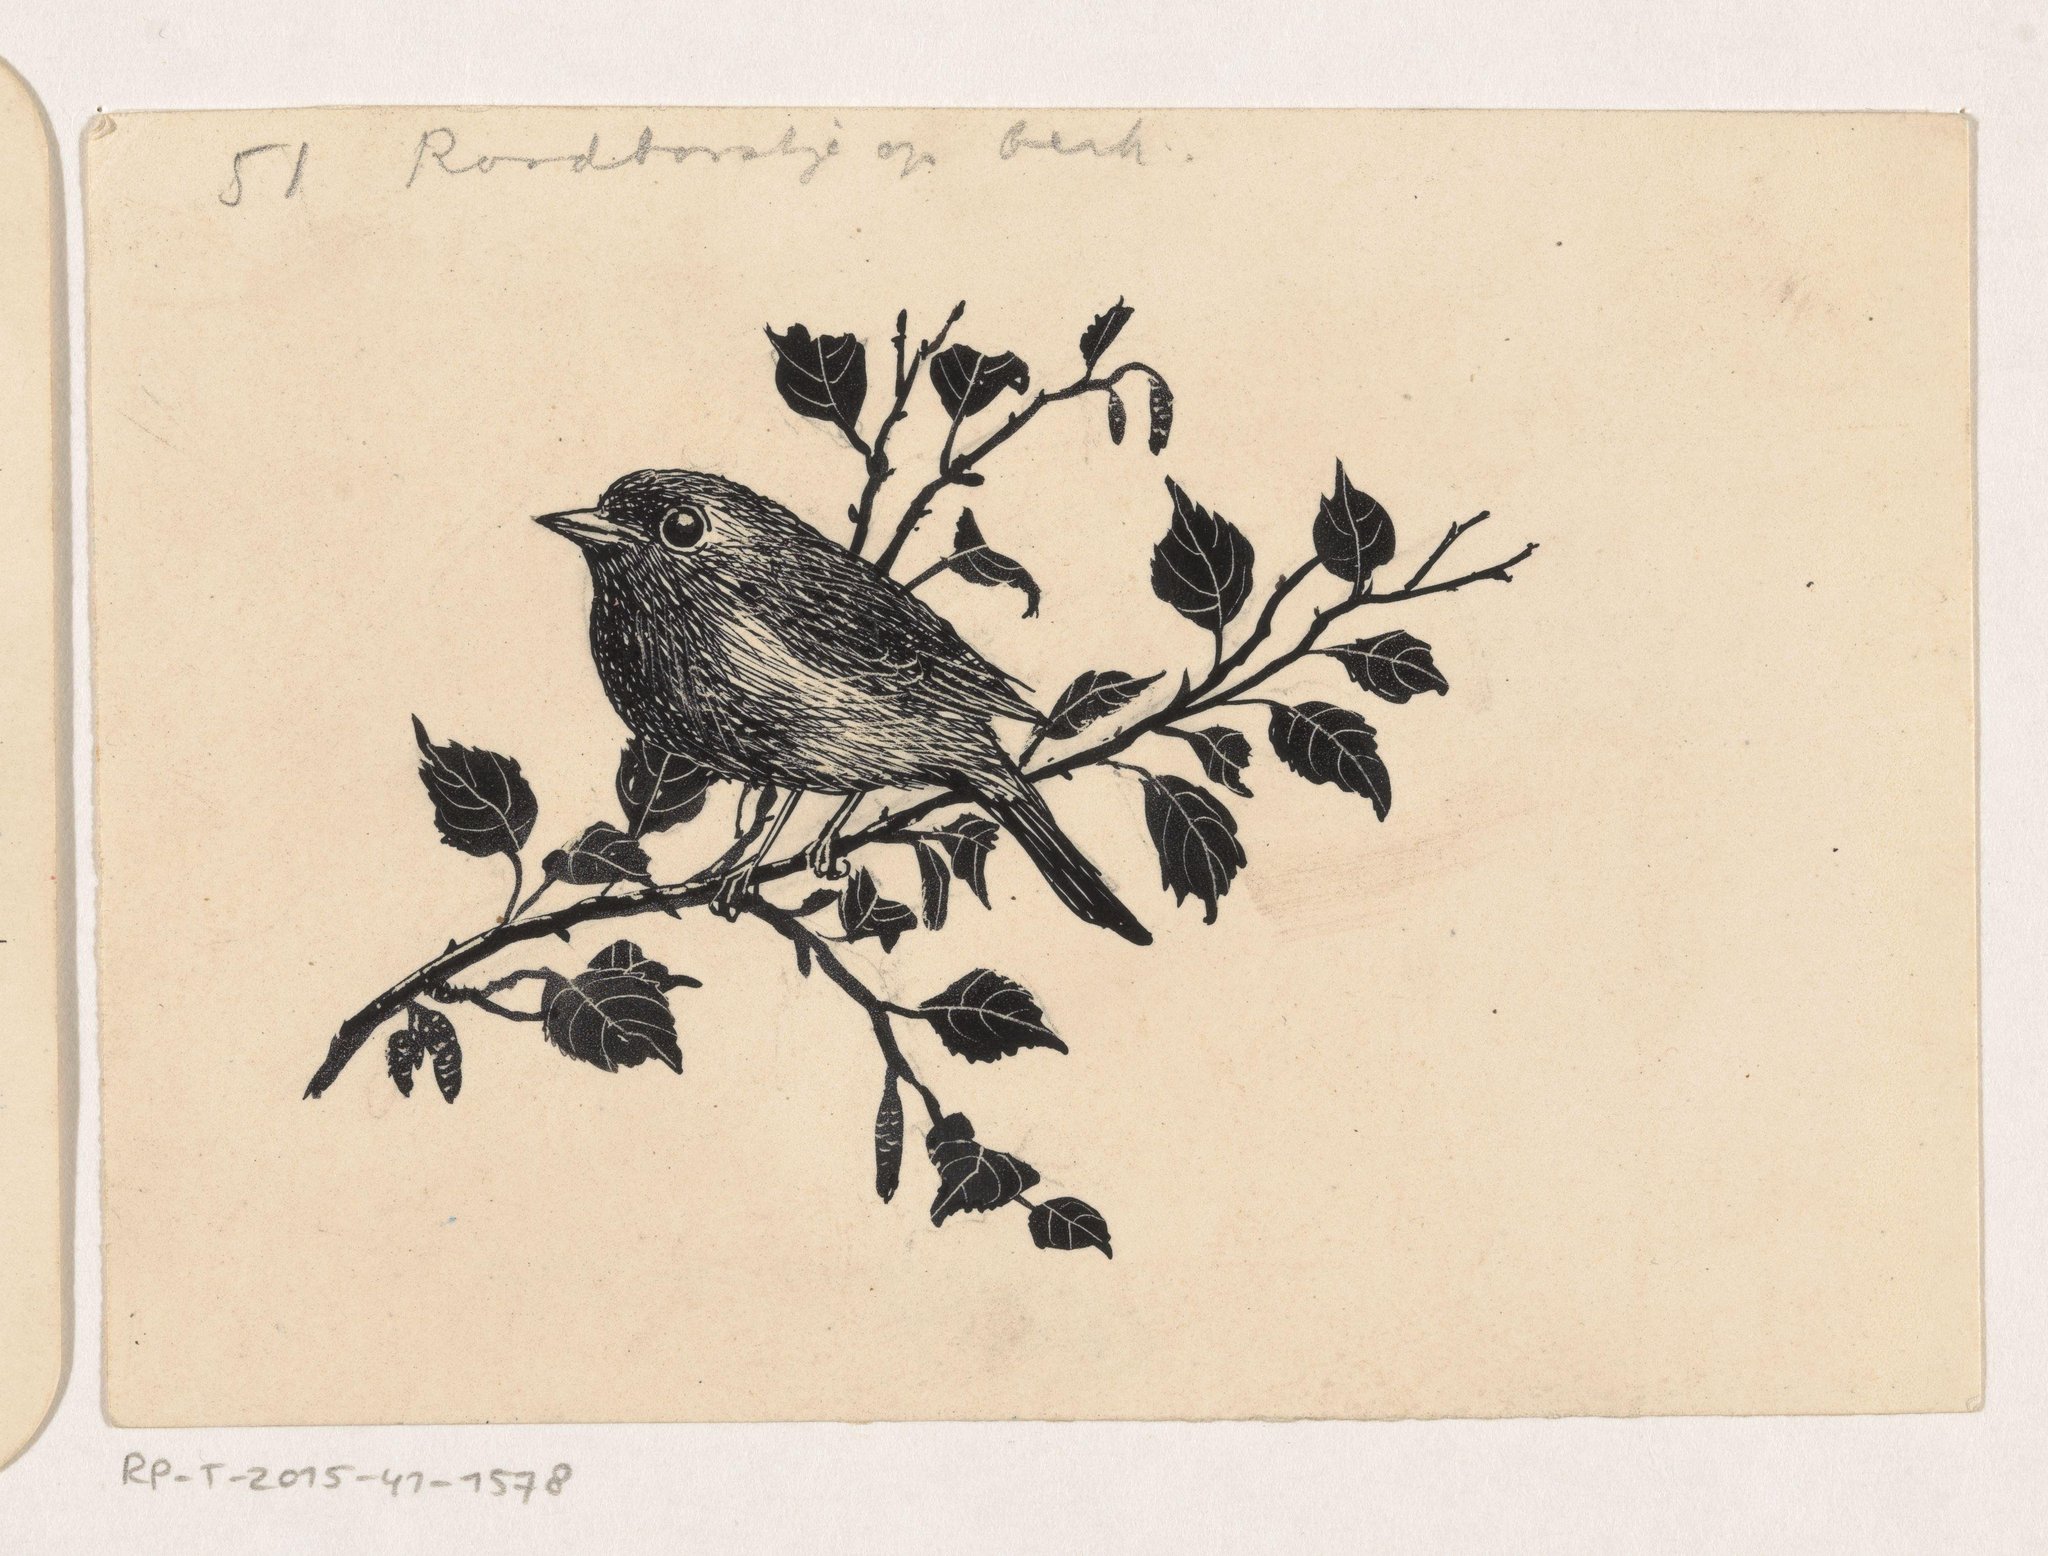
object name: boekillustratie ontwerp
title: Roodborstje op een berkentak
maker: henri verstijnen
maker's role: draughtsman, print maker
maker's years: 1882-1940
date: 1933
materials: ink, paper, pencil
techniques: pen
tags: song-birds: robin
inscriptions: annotation: ‘Droeg op zijn rug’, annotation: ‘51 Roodborstje op berk.’, :, collector's mark: Lugt 2228